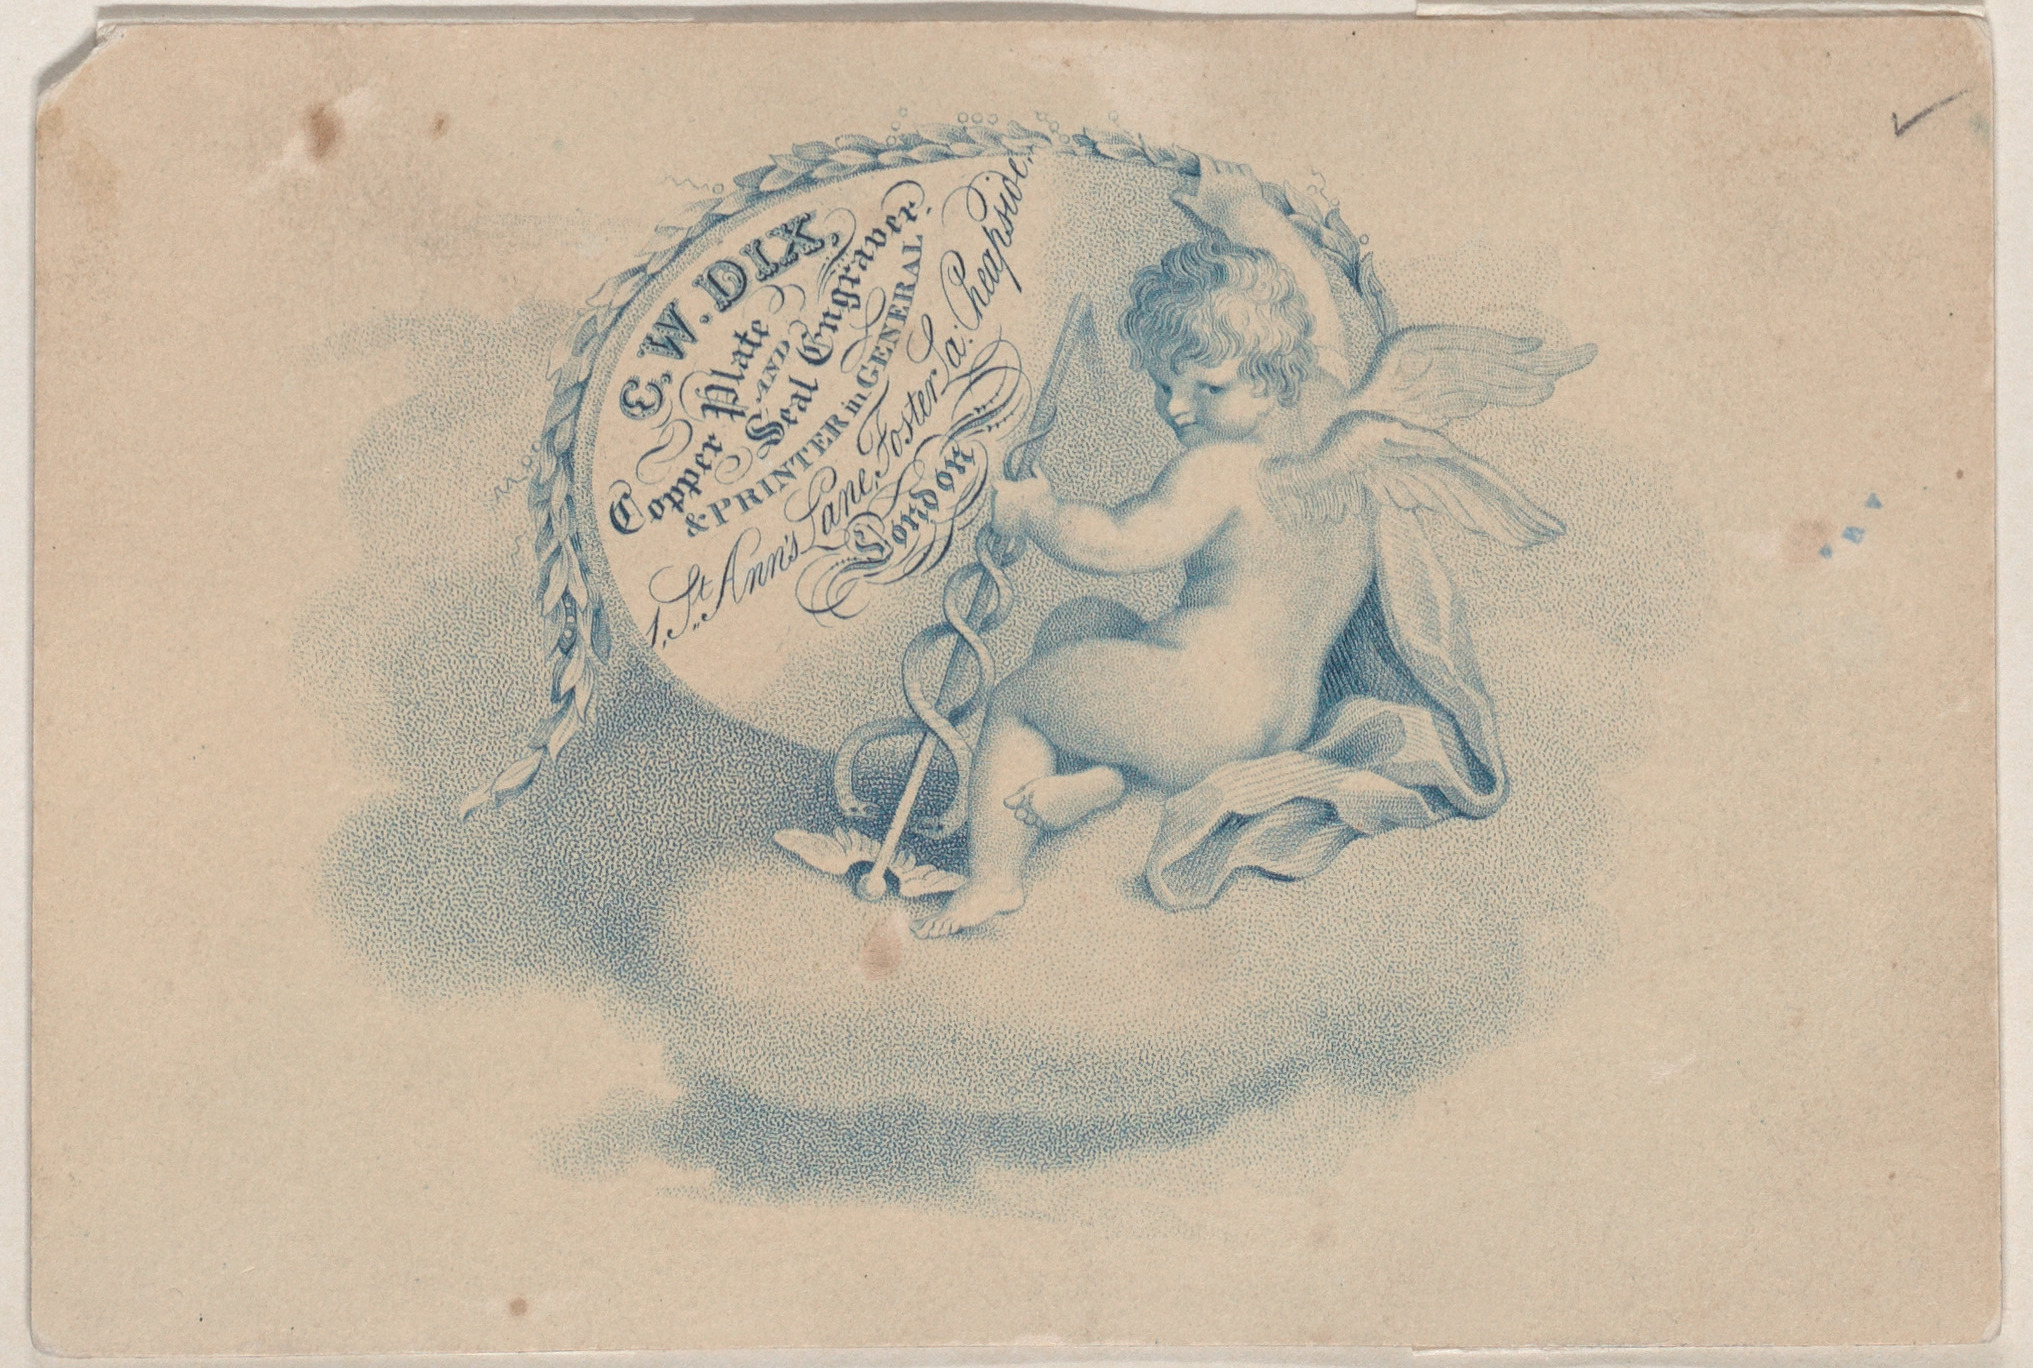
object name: print, trade card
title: Trade card for C.W. Dix, Printer and Engraver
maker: anonymous, british, 18th century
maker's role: artist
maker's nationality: british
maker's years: 1700-1800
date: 1801-1900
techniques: etching